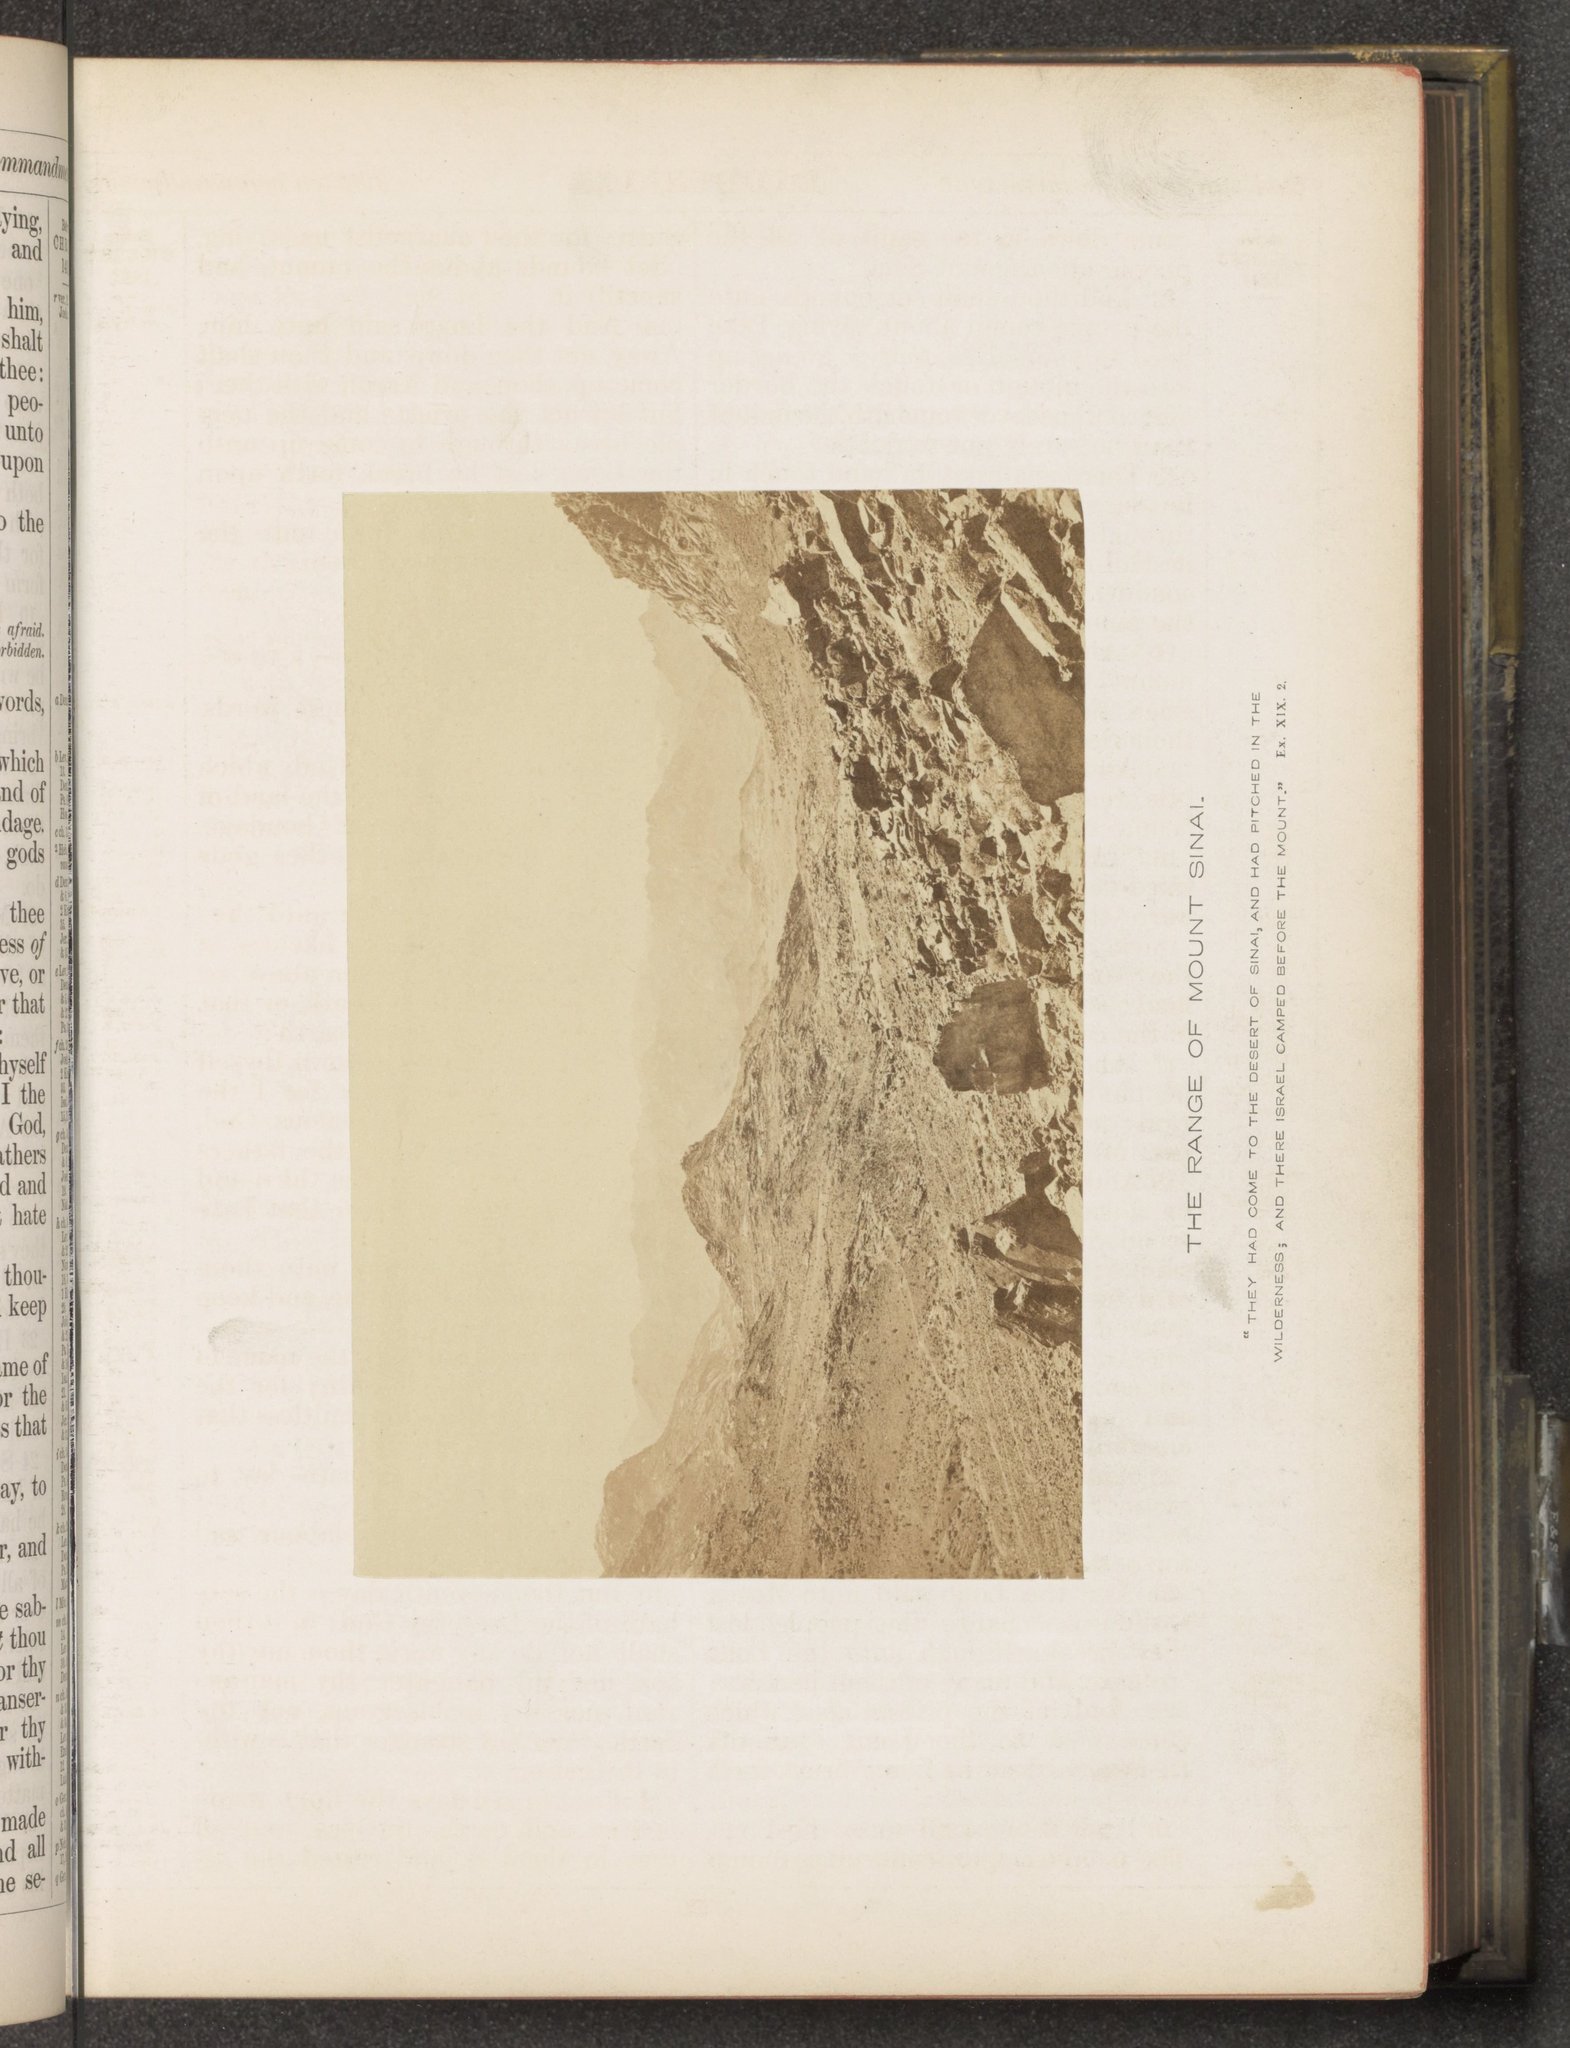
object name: photograph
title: The range of Mount Sinai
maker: francis frith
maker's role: publisher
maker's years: 1822-1898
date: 1850-1865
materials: photographic support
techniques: albumen print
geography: mount sinai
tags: mountains, mount sinai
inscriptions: inscription: ‘"They had come to the dessert of Sinai, and had pitched in the wilderness; and there Israel camped before the mount."Ex. XIX.2.’